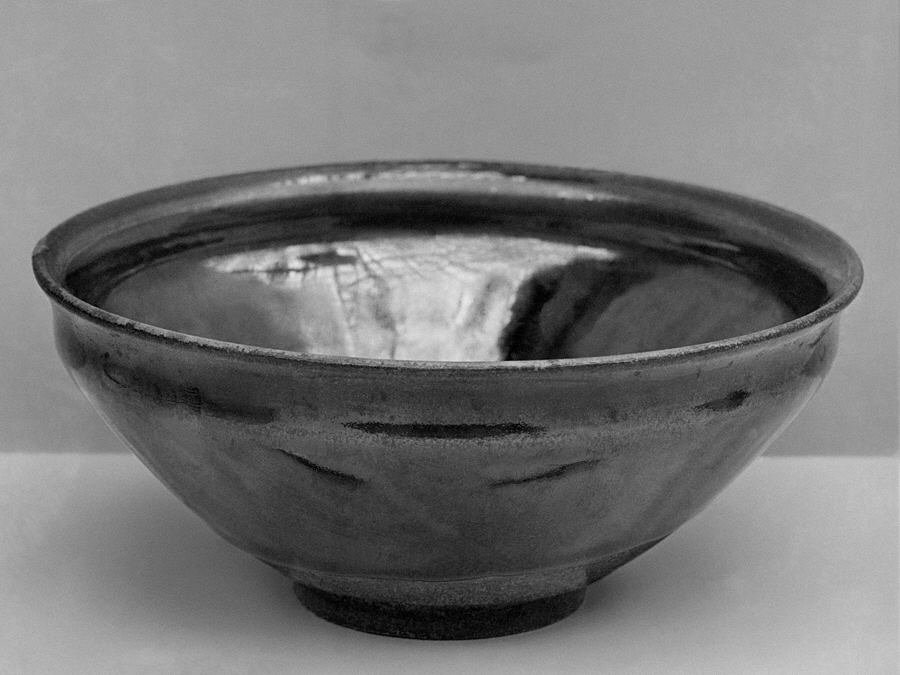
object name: bowl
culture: chinese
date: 960-1279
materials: clay, glaze